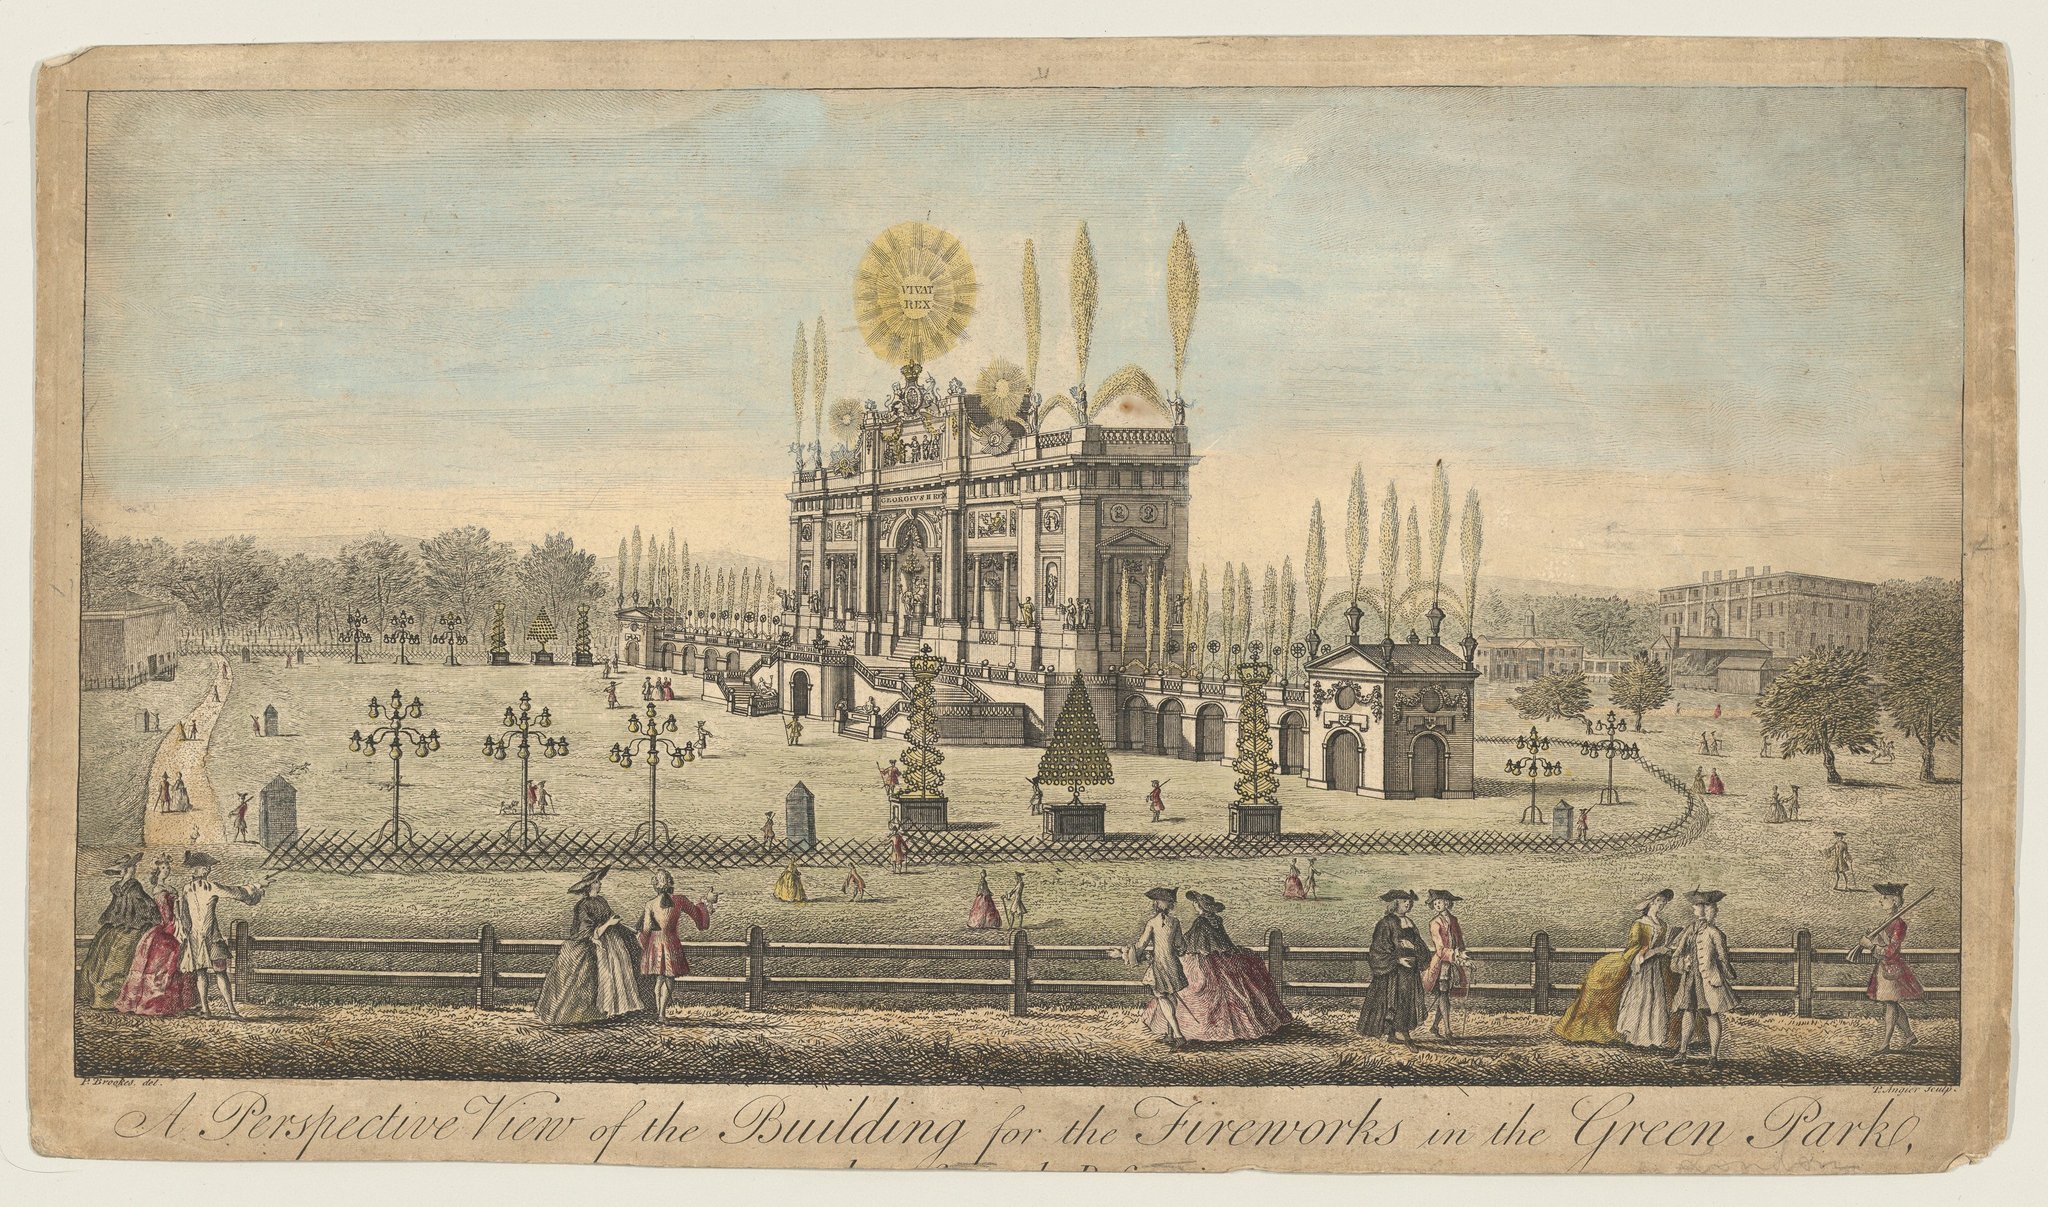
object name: print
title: A Perspective View of the Building for the Fireworks in the Green Park taken from the Reservoir, London, 1814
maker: paul angier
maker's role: artist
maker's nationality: french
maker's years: 1749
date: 1814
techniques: etching, hand coloring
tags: buildings,parks,fireworks,london